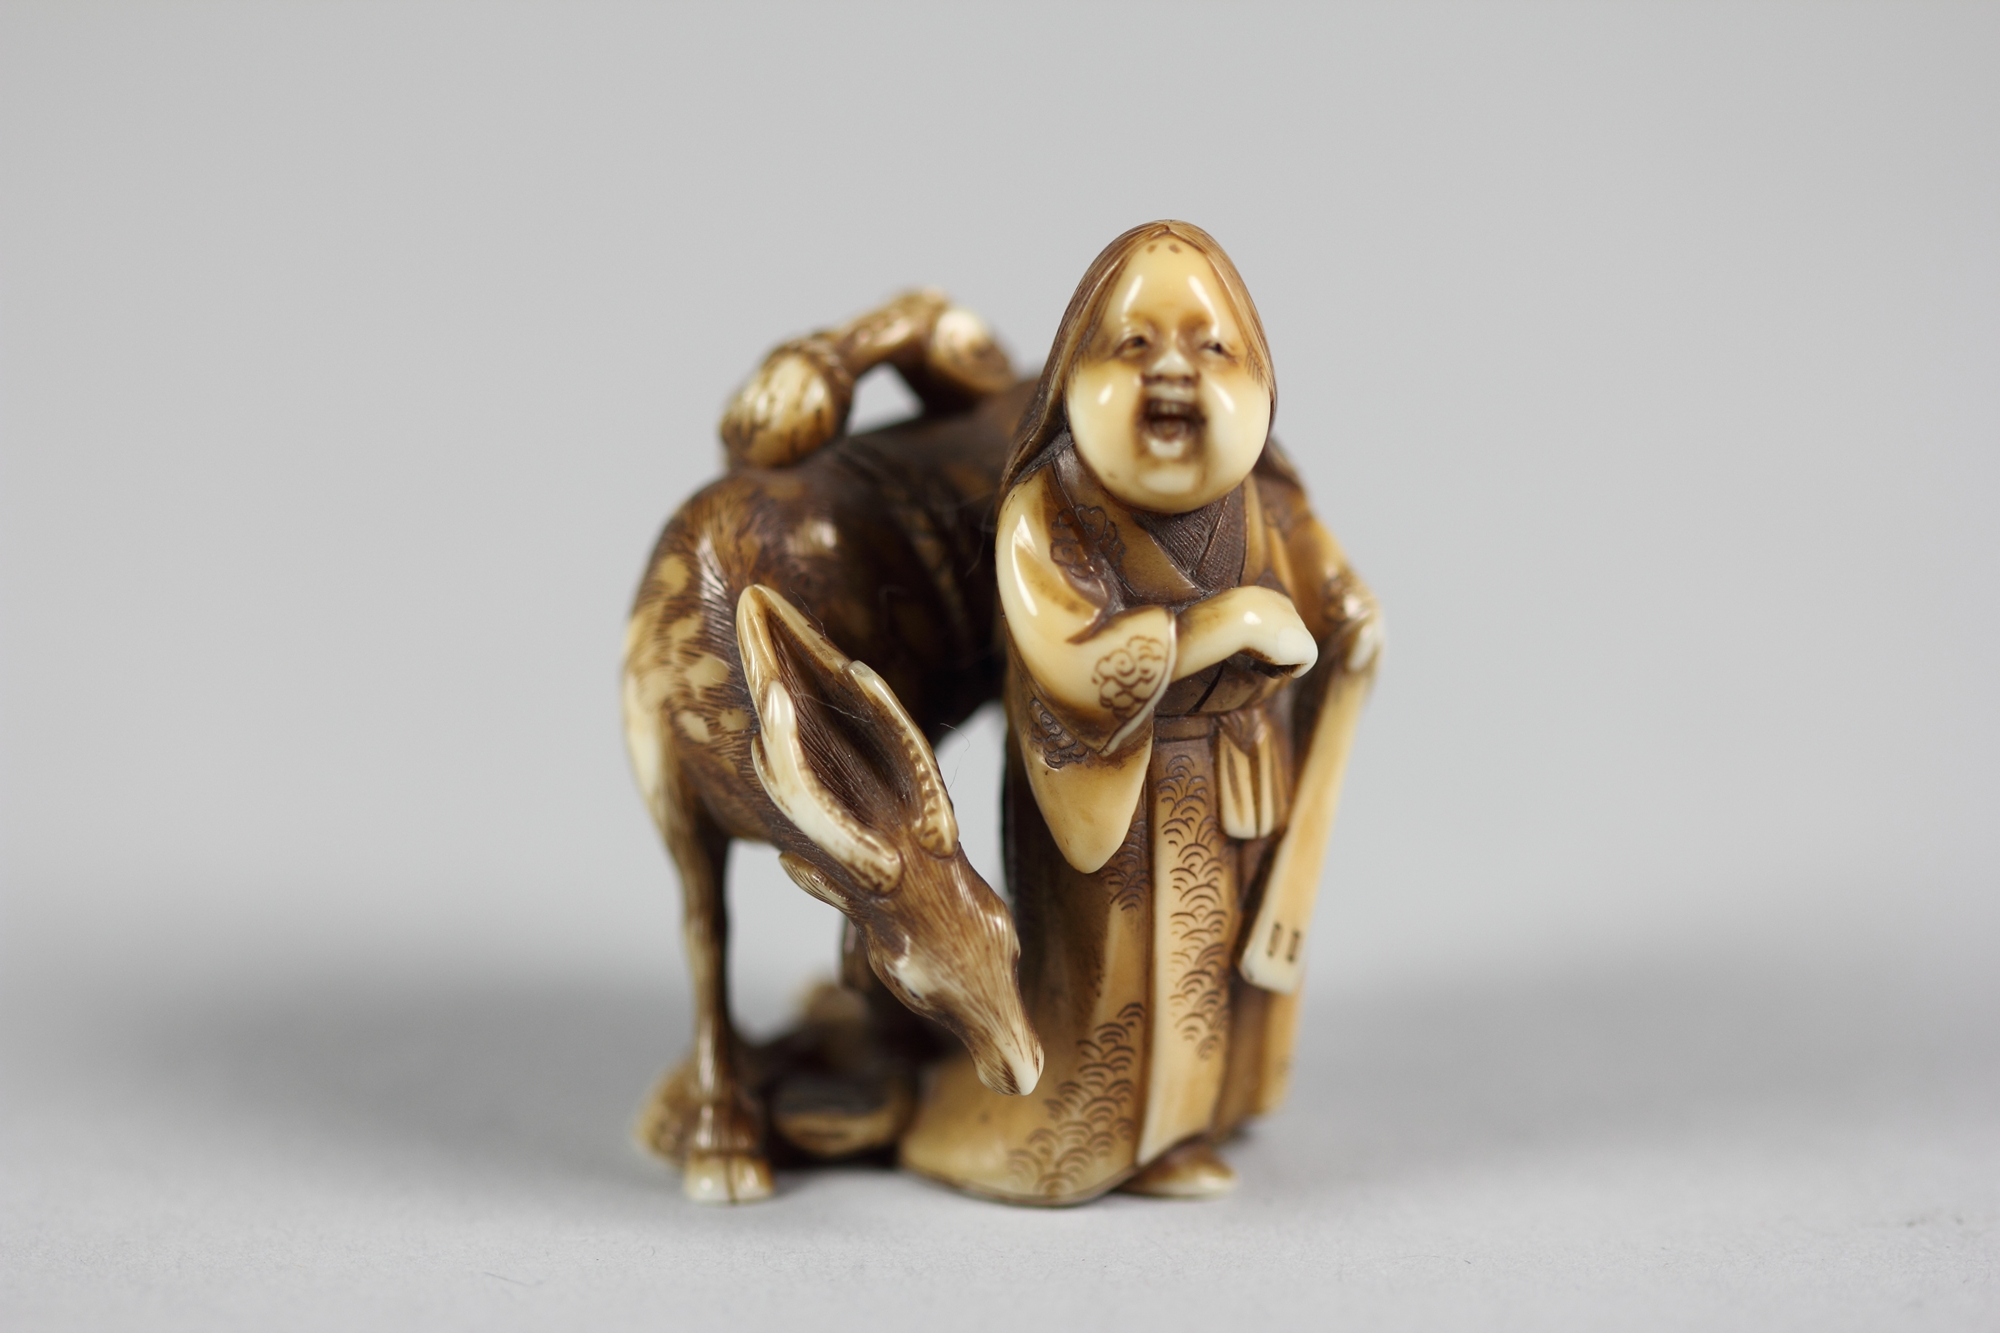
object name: netsuke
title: Netsuke of Female Figure (Okame) with a Deer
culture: japanese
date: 1767-1800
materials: ivory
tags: women